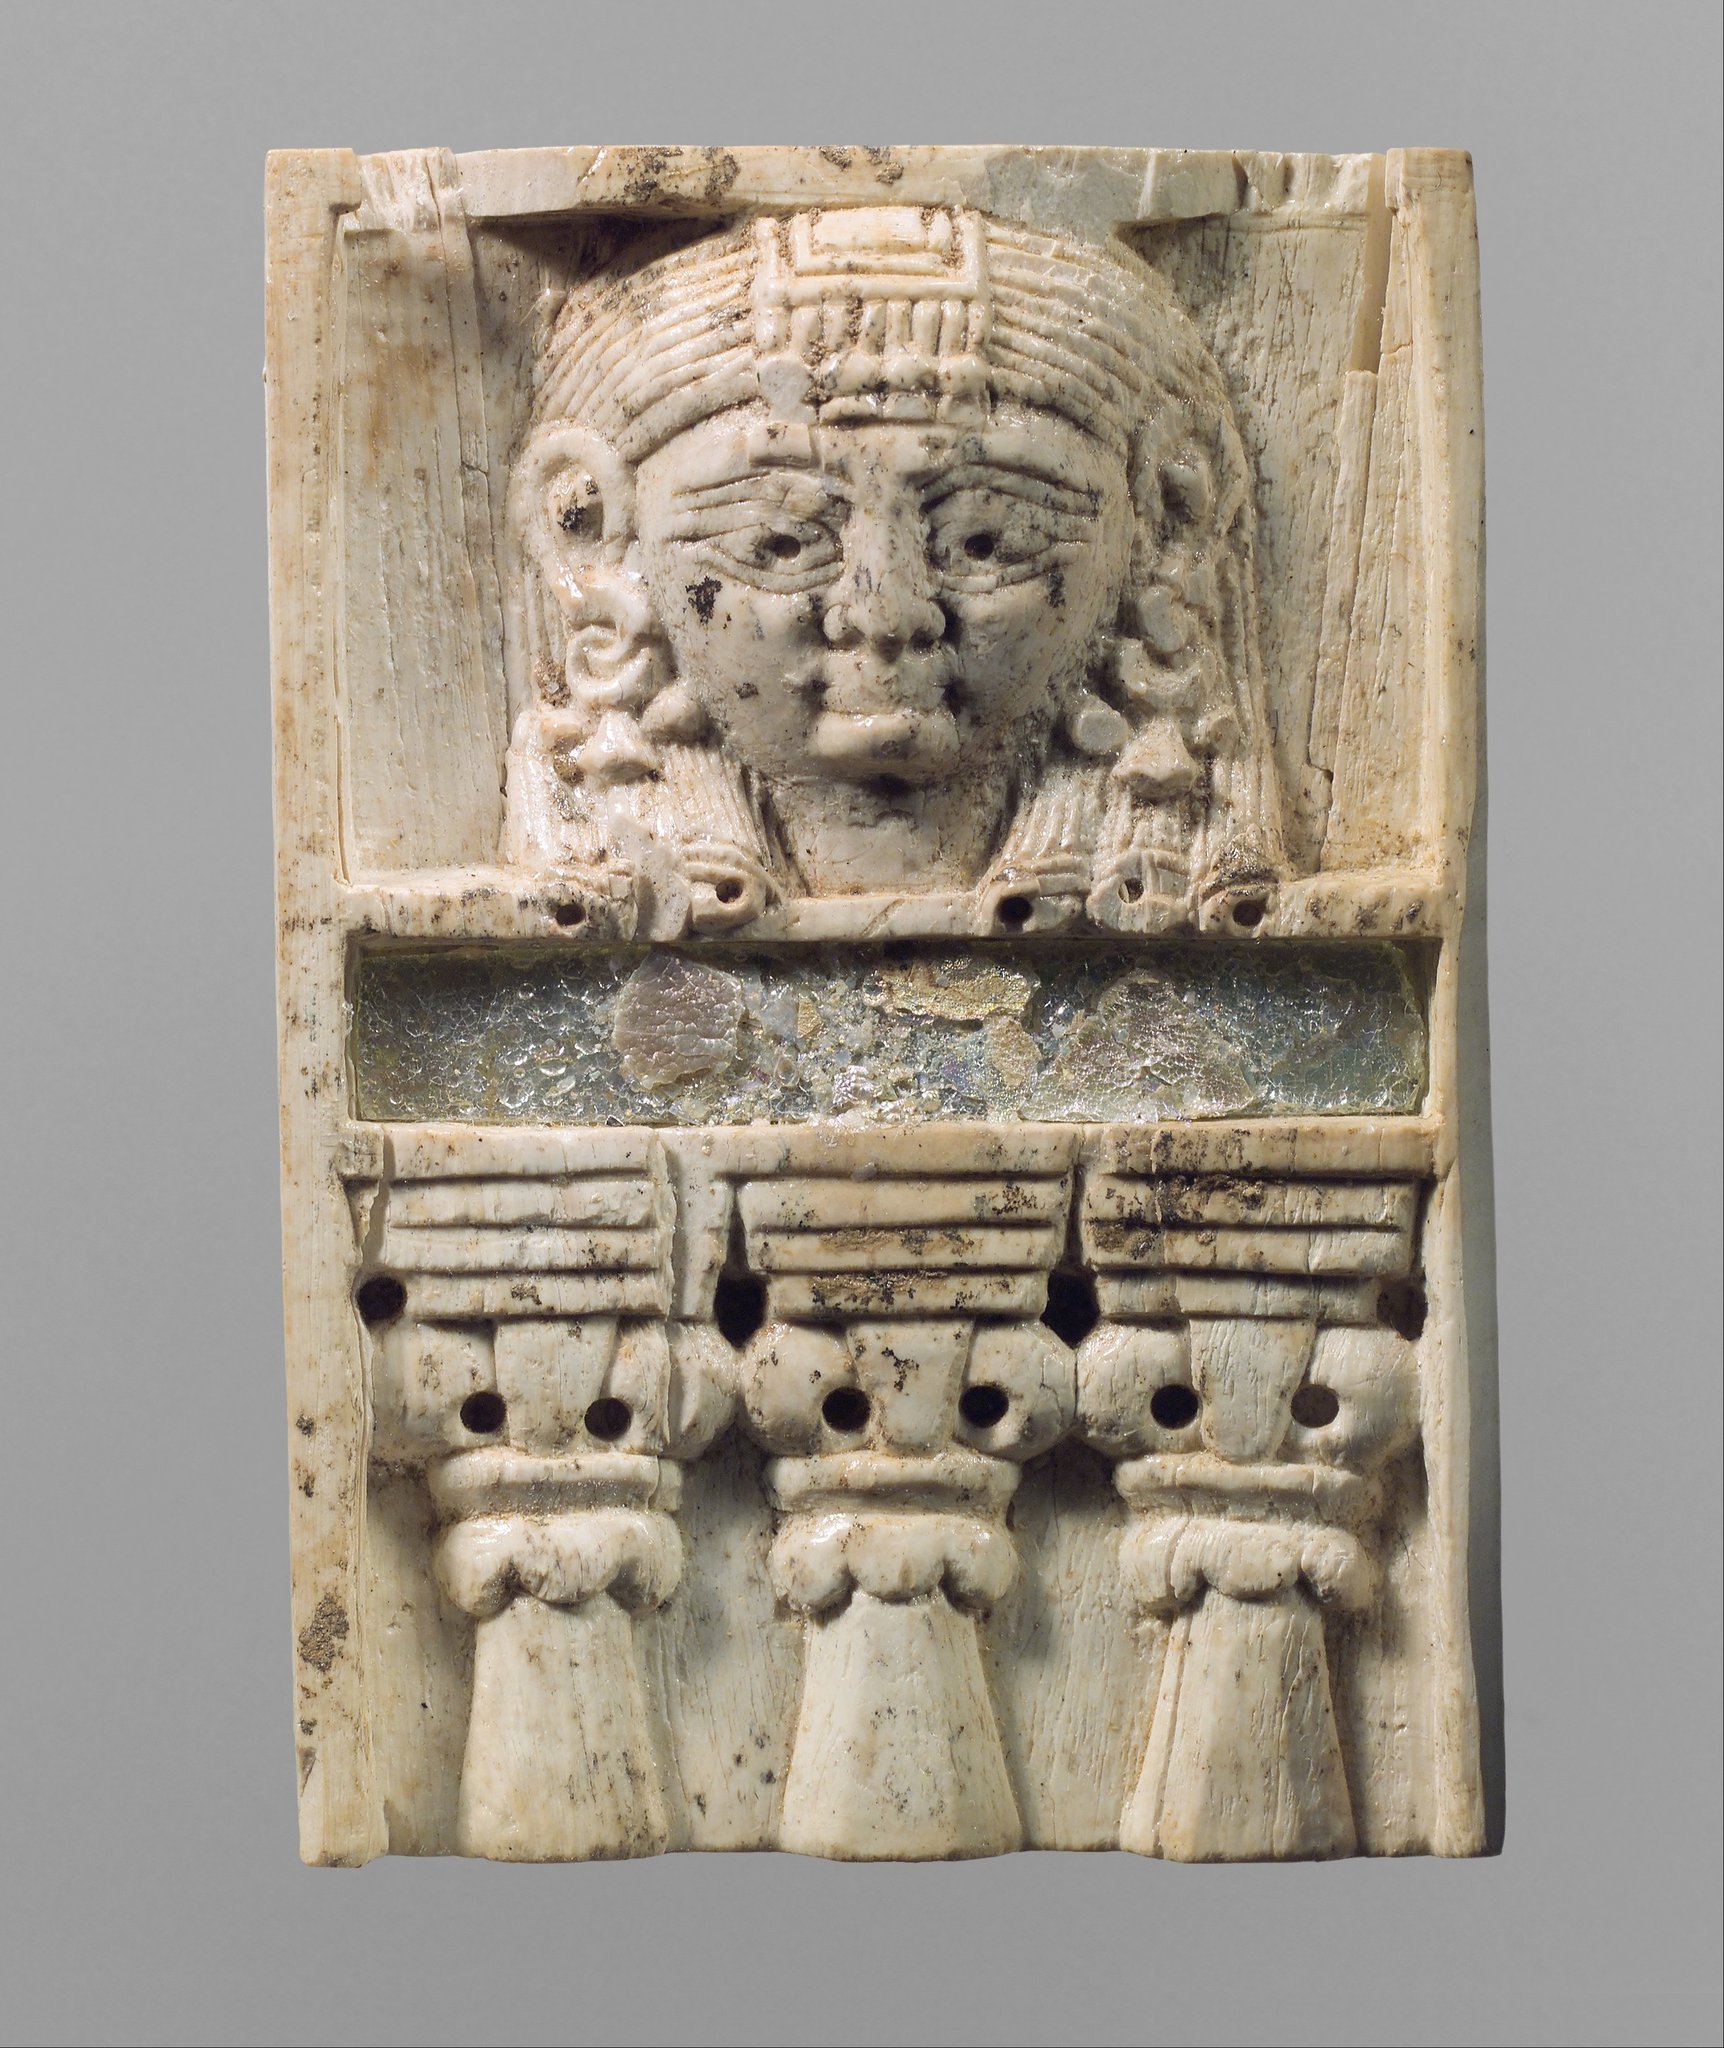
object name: furniture element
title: Furniture plaque carved in relief with a “woman at the window”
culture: assyrian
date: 900-701 BCE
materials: glass, ivory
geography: syria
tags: women